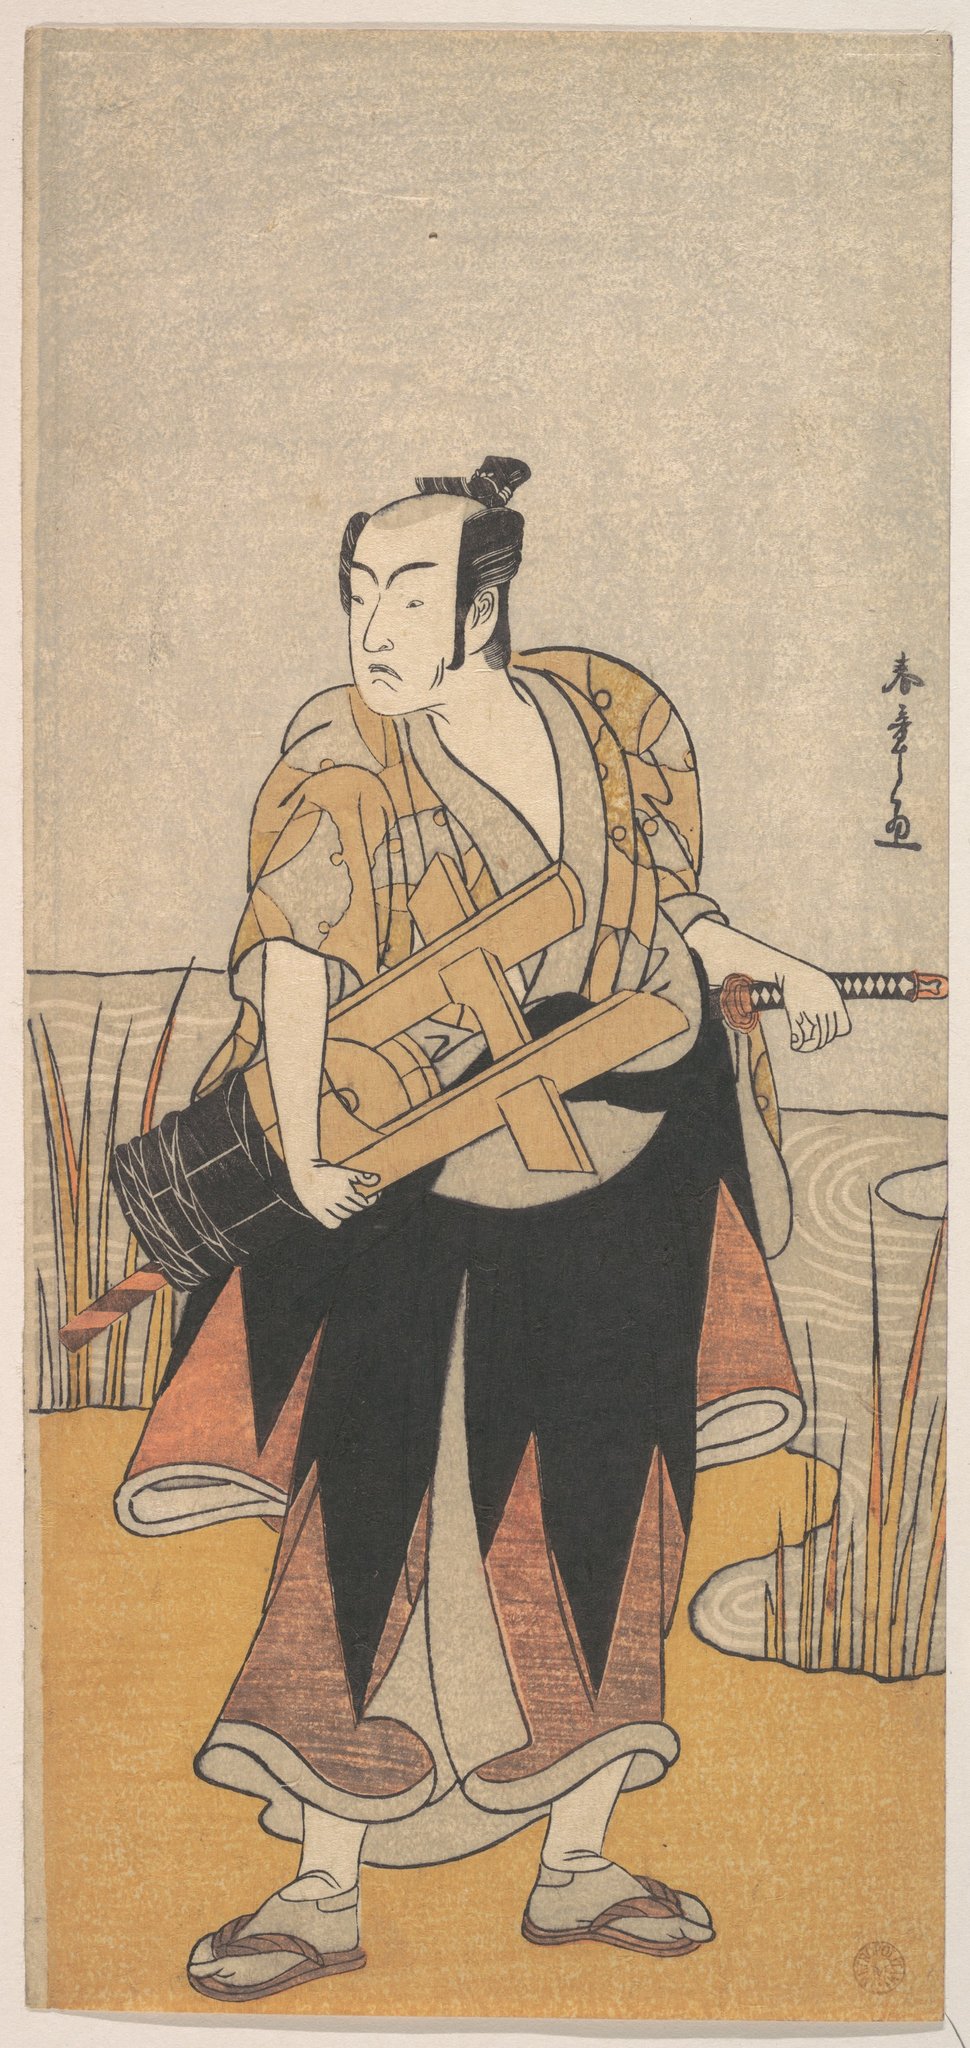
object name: woodblock print nishiki e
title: The Fourth Matsumoto Koshiro as a Man Standing on the Bank of a River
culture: japanese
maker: katsukawa shunshō 勝川春章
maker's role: artist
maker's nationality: japanese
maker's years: 1726-1792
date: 1785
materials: ink, paper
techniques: nishiki e, woodblock print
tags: men,rivers,actors